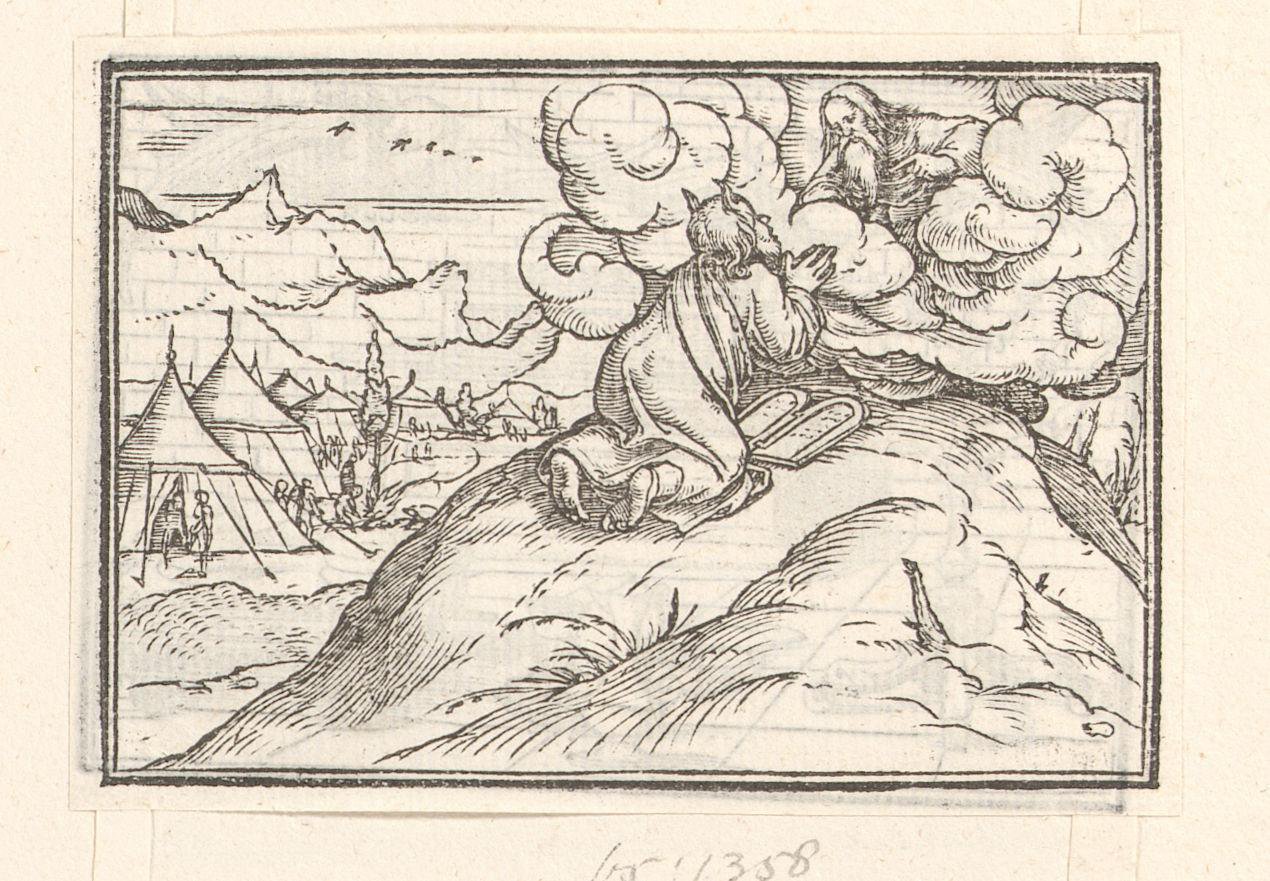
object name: print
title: Geschiedenis van het Oude Testament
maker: veit rudolf specklin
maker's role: print maker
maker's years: -1550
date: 1538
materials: paper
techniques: woodcut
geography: switzerland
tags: moses receives the tables of the law from god, moses on mount sinai with the tables of the law (exodus 24:9-18, 31:18)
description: Boekillustratie voor het eerst gebruikt in: Biblia Utriusque Testamenti iuxta Vulgatam Translationem, Lyon, M. en G. Trechsel (voor Hugo à Porta) 1538. Later in verschillende uitgaven opnieuw gebruikt. Deze prent vermoedelijk gebruikt in één van de uitgaven uitgegeven en/of gedrukt door Jean Frellon, Lyon.